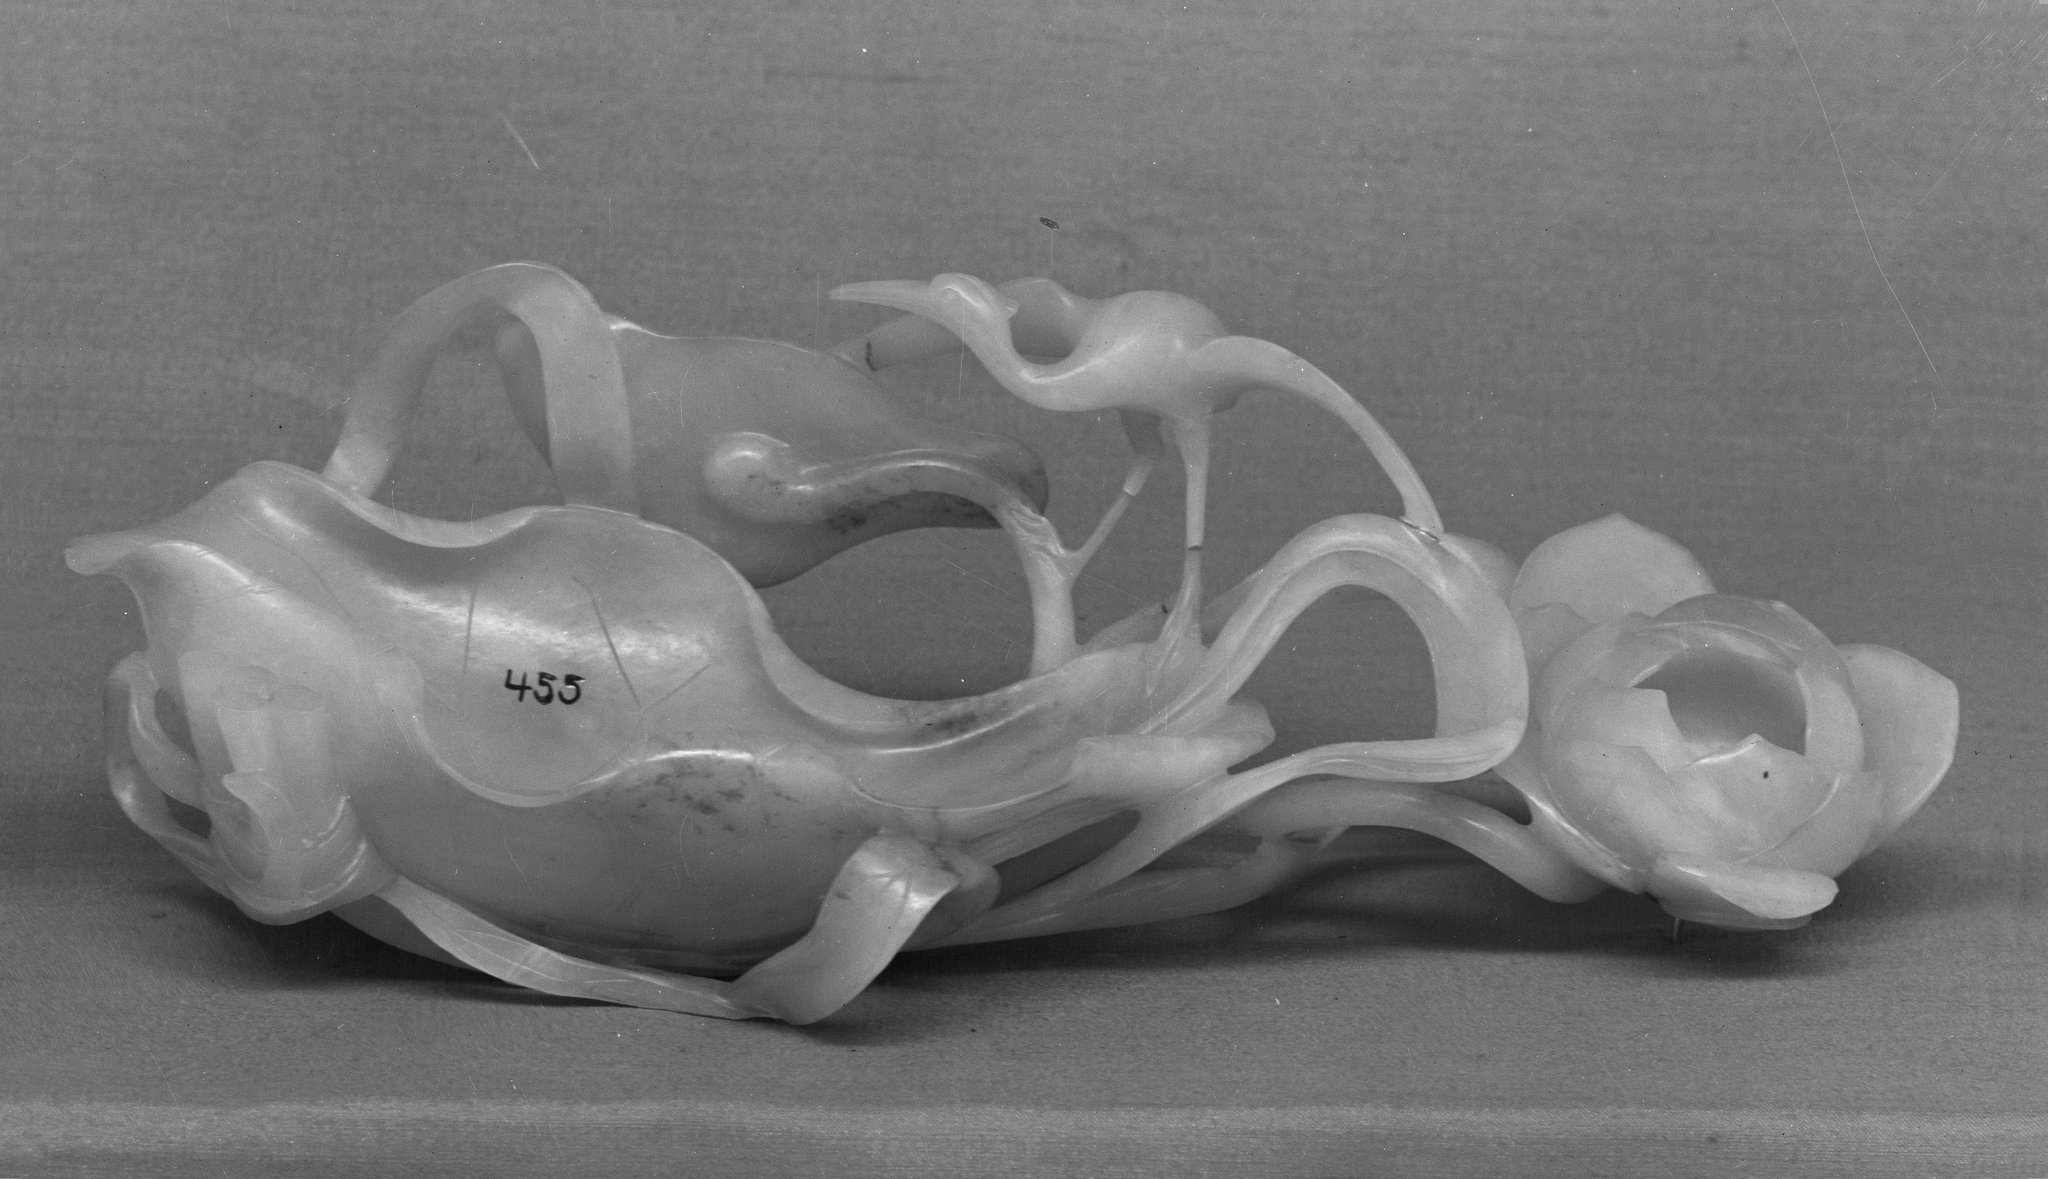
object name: water holder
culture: chinese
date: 1701-1800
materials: jade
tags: birds